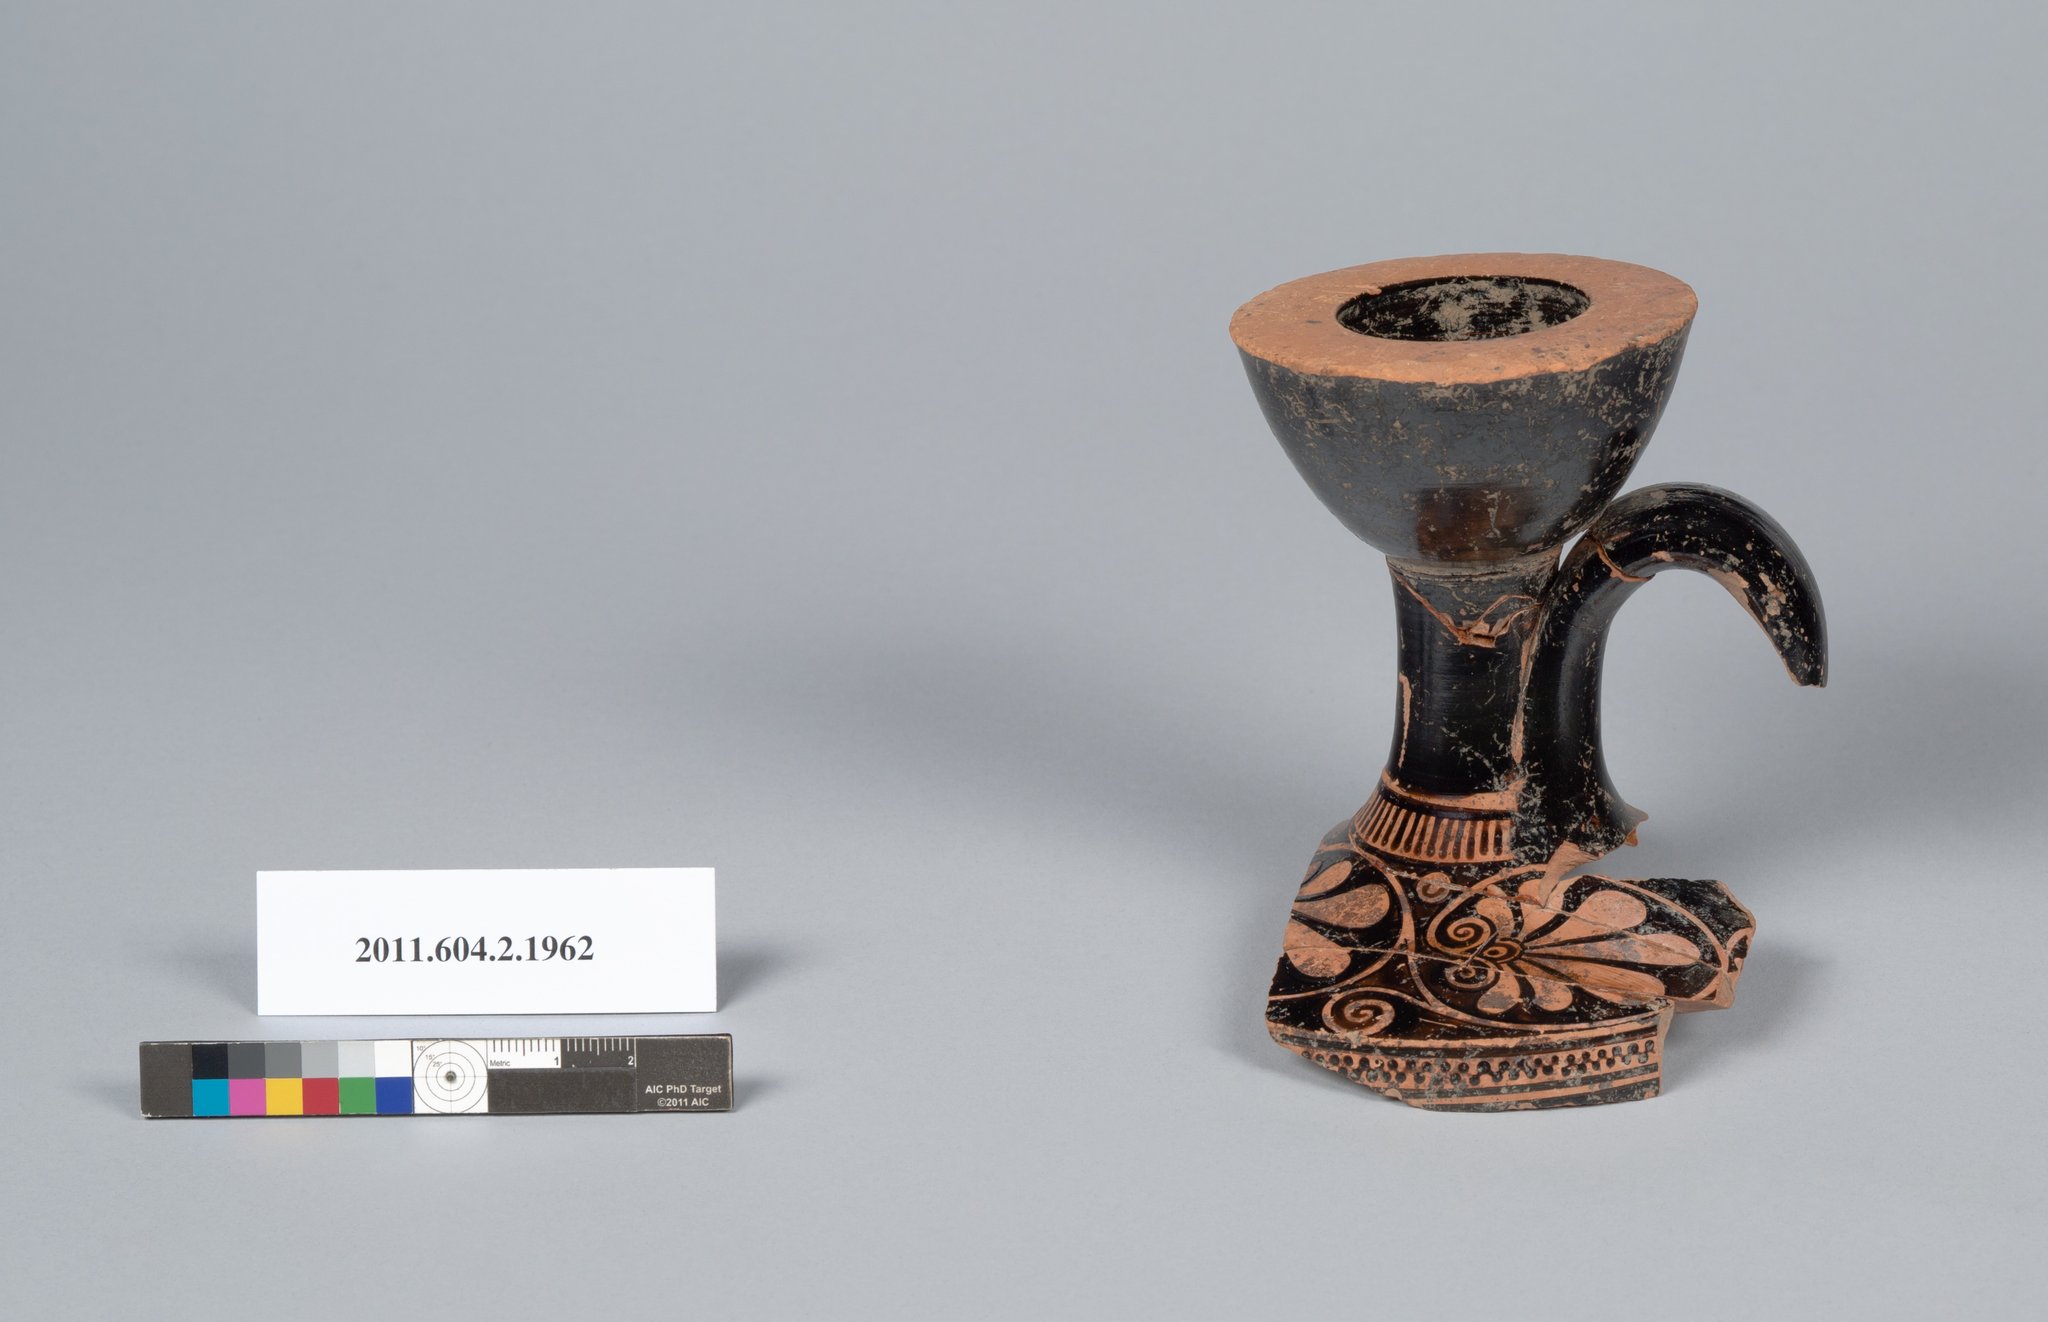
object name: lekythos fragment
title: Terracotta fragment of a lekythos (oil flask)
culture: greek, attic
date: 490-480 BCE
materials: terracotta